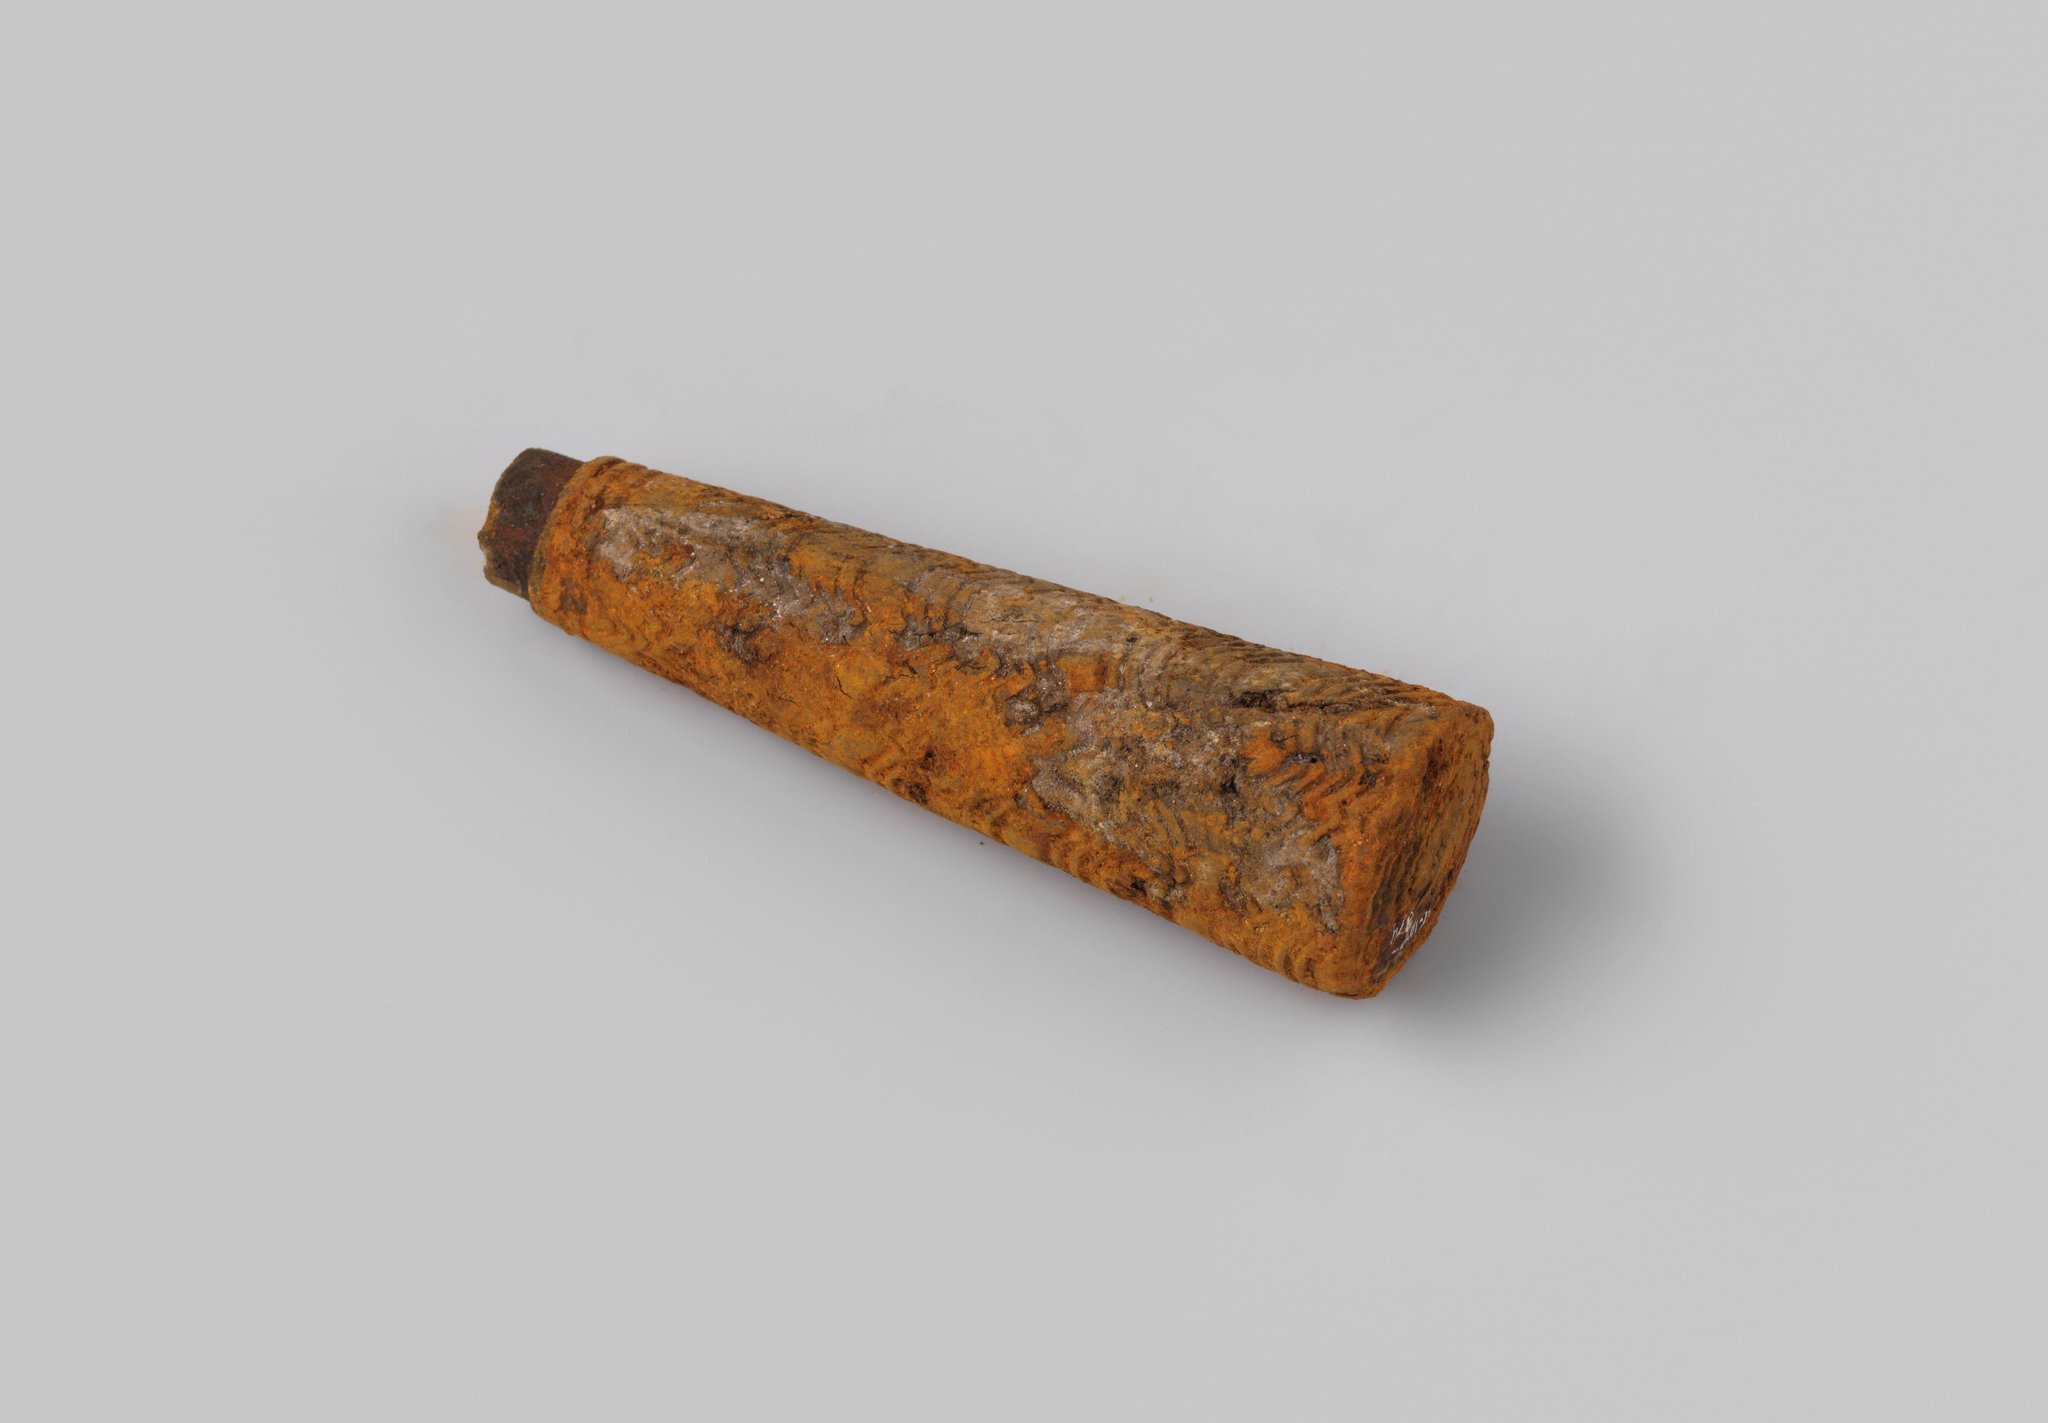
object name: knife handle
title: Messenheft uit het wrak van de Oost-Indiëvaarder Hollandia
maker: Anonymous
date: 1700-1743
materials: wood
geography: netherlands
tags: verenigde oostindische compagnie, hollandia (schip), annet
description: Knife, handle, cylindrical: tapering; id. NG 1979-403H, ferrules id. NG 1980-27H426.